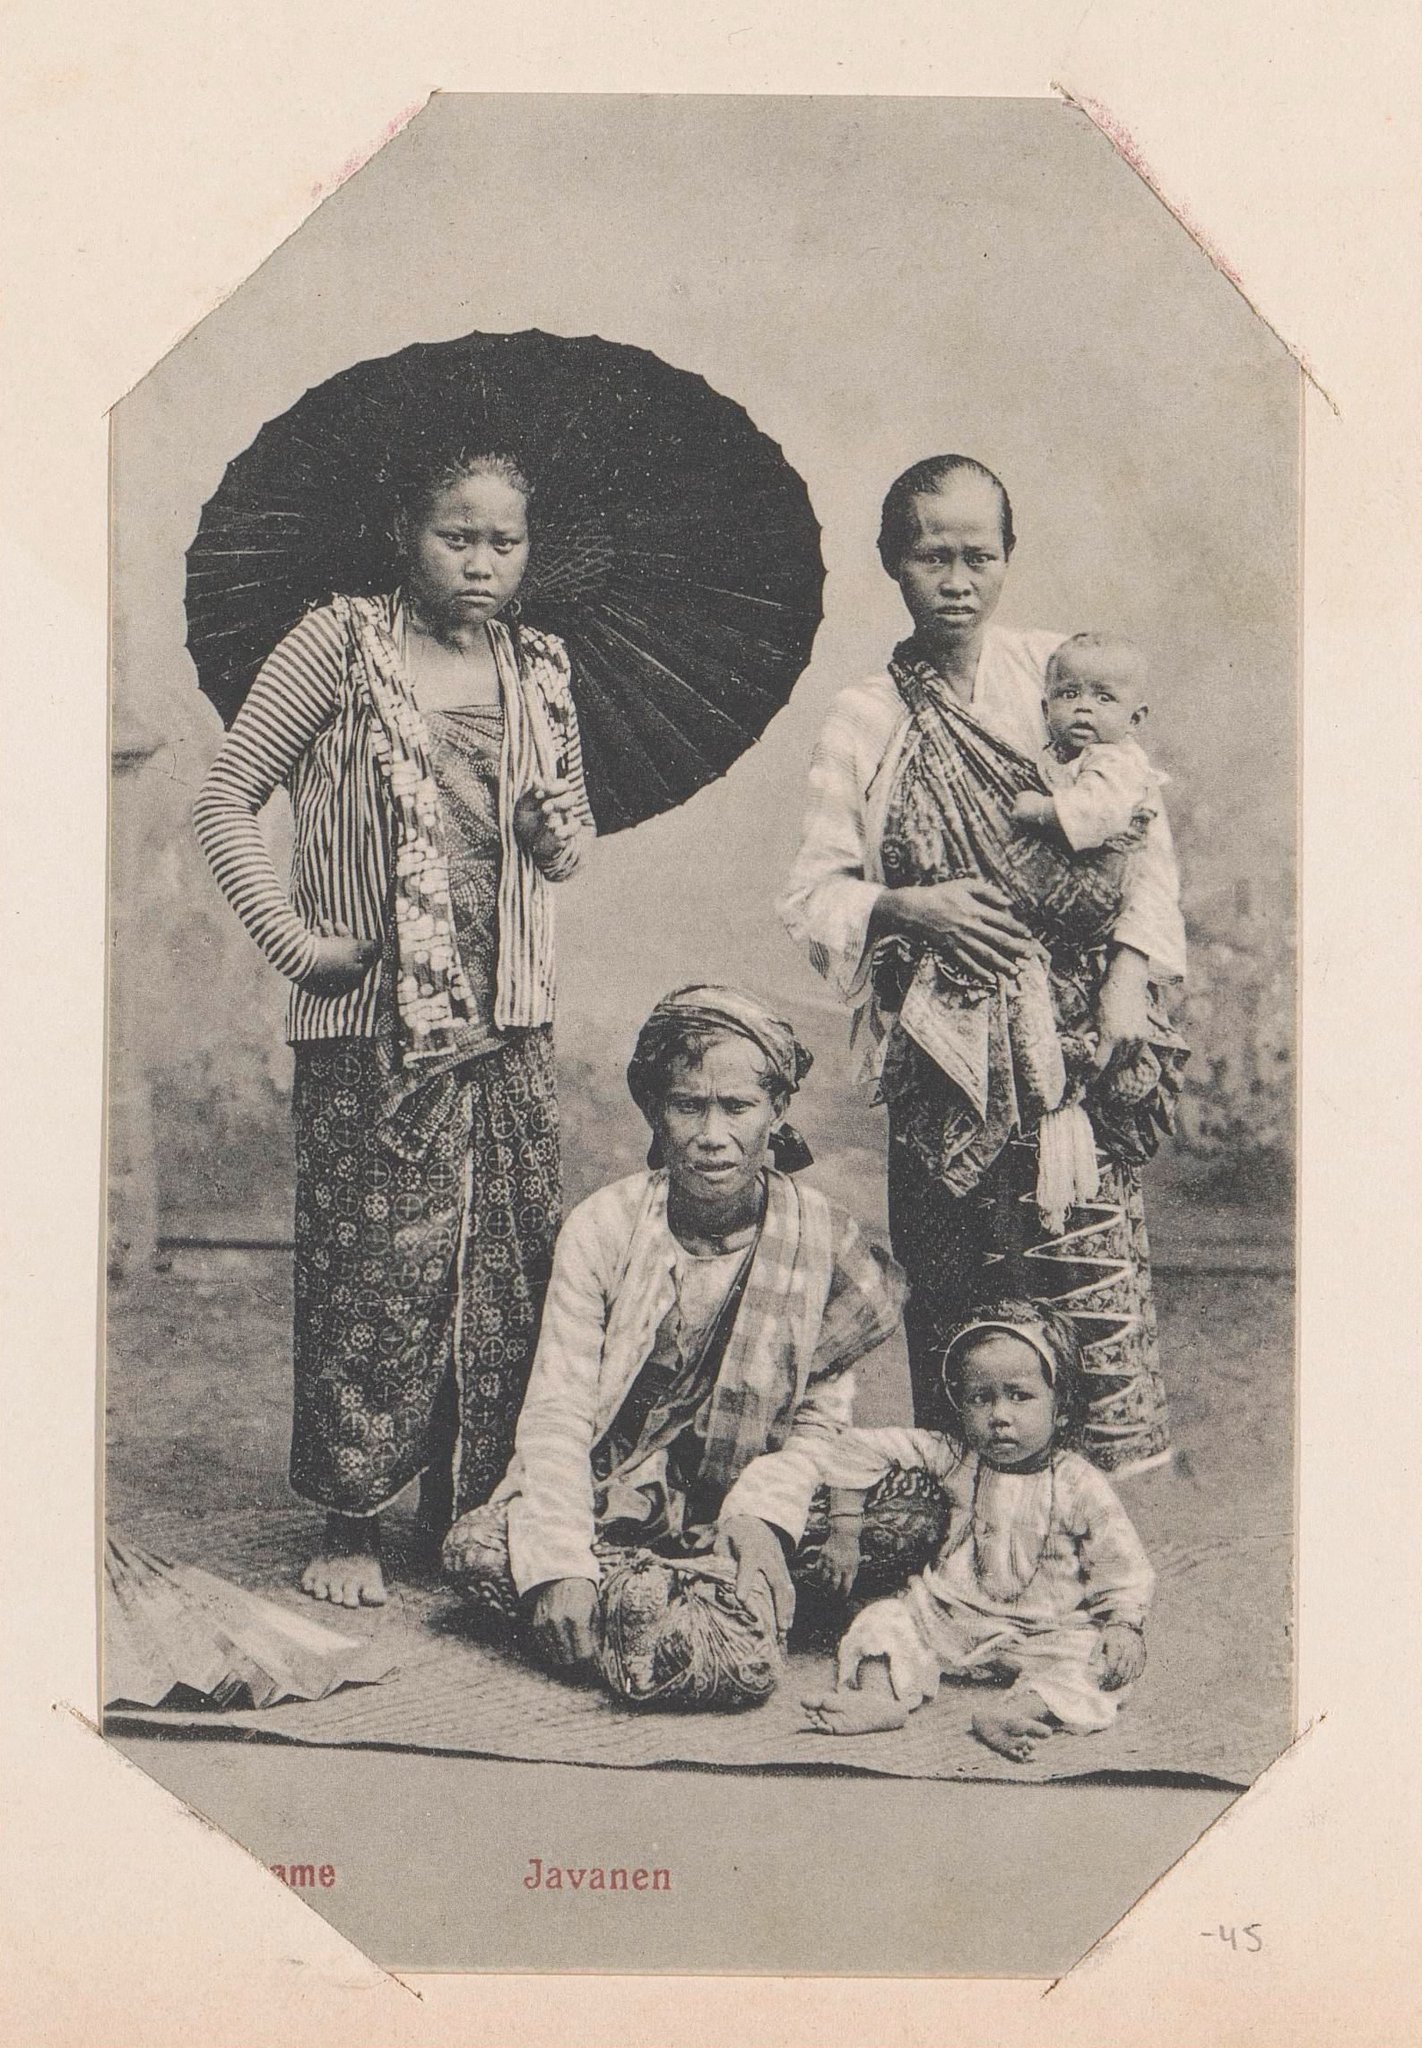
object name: ansichtkaart, prentbriefkaart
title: Mensen van Javaanse oorsprong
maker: eugen klein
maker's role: fotograaf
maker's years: 1869-1927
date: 1900-1910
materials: cardboard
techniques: photograph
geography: suriname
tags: parents with their children, suriname, java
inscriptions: serial number: ‘Eigendom van Eugen Klein, Paramaribo No. 183’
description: Portret van een groep van mensen van Javaanse oorsprong, mogelijk een familie. Onderdeel van een verzameling van 68 briefkaarten uit Suriname, bijeengebracht in een album als aandenken aan een verblijf in Suriname in september 1911.